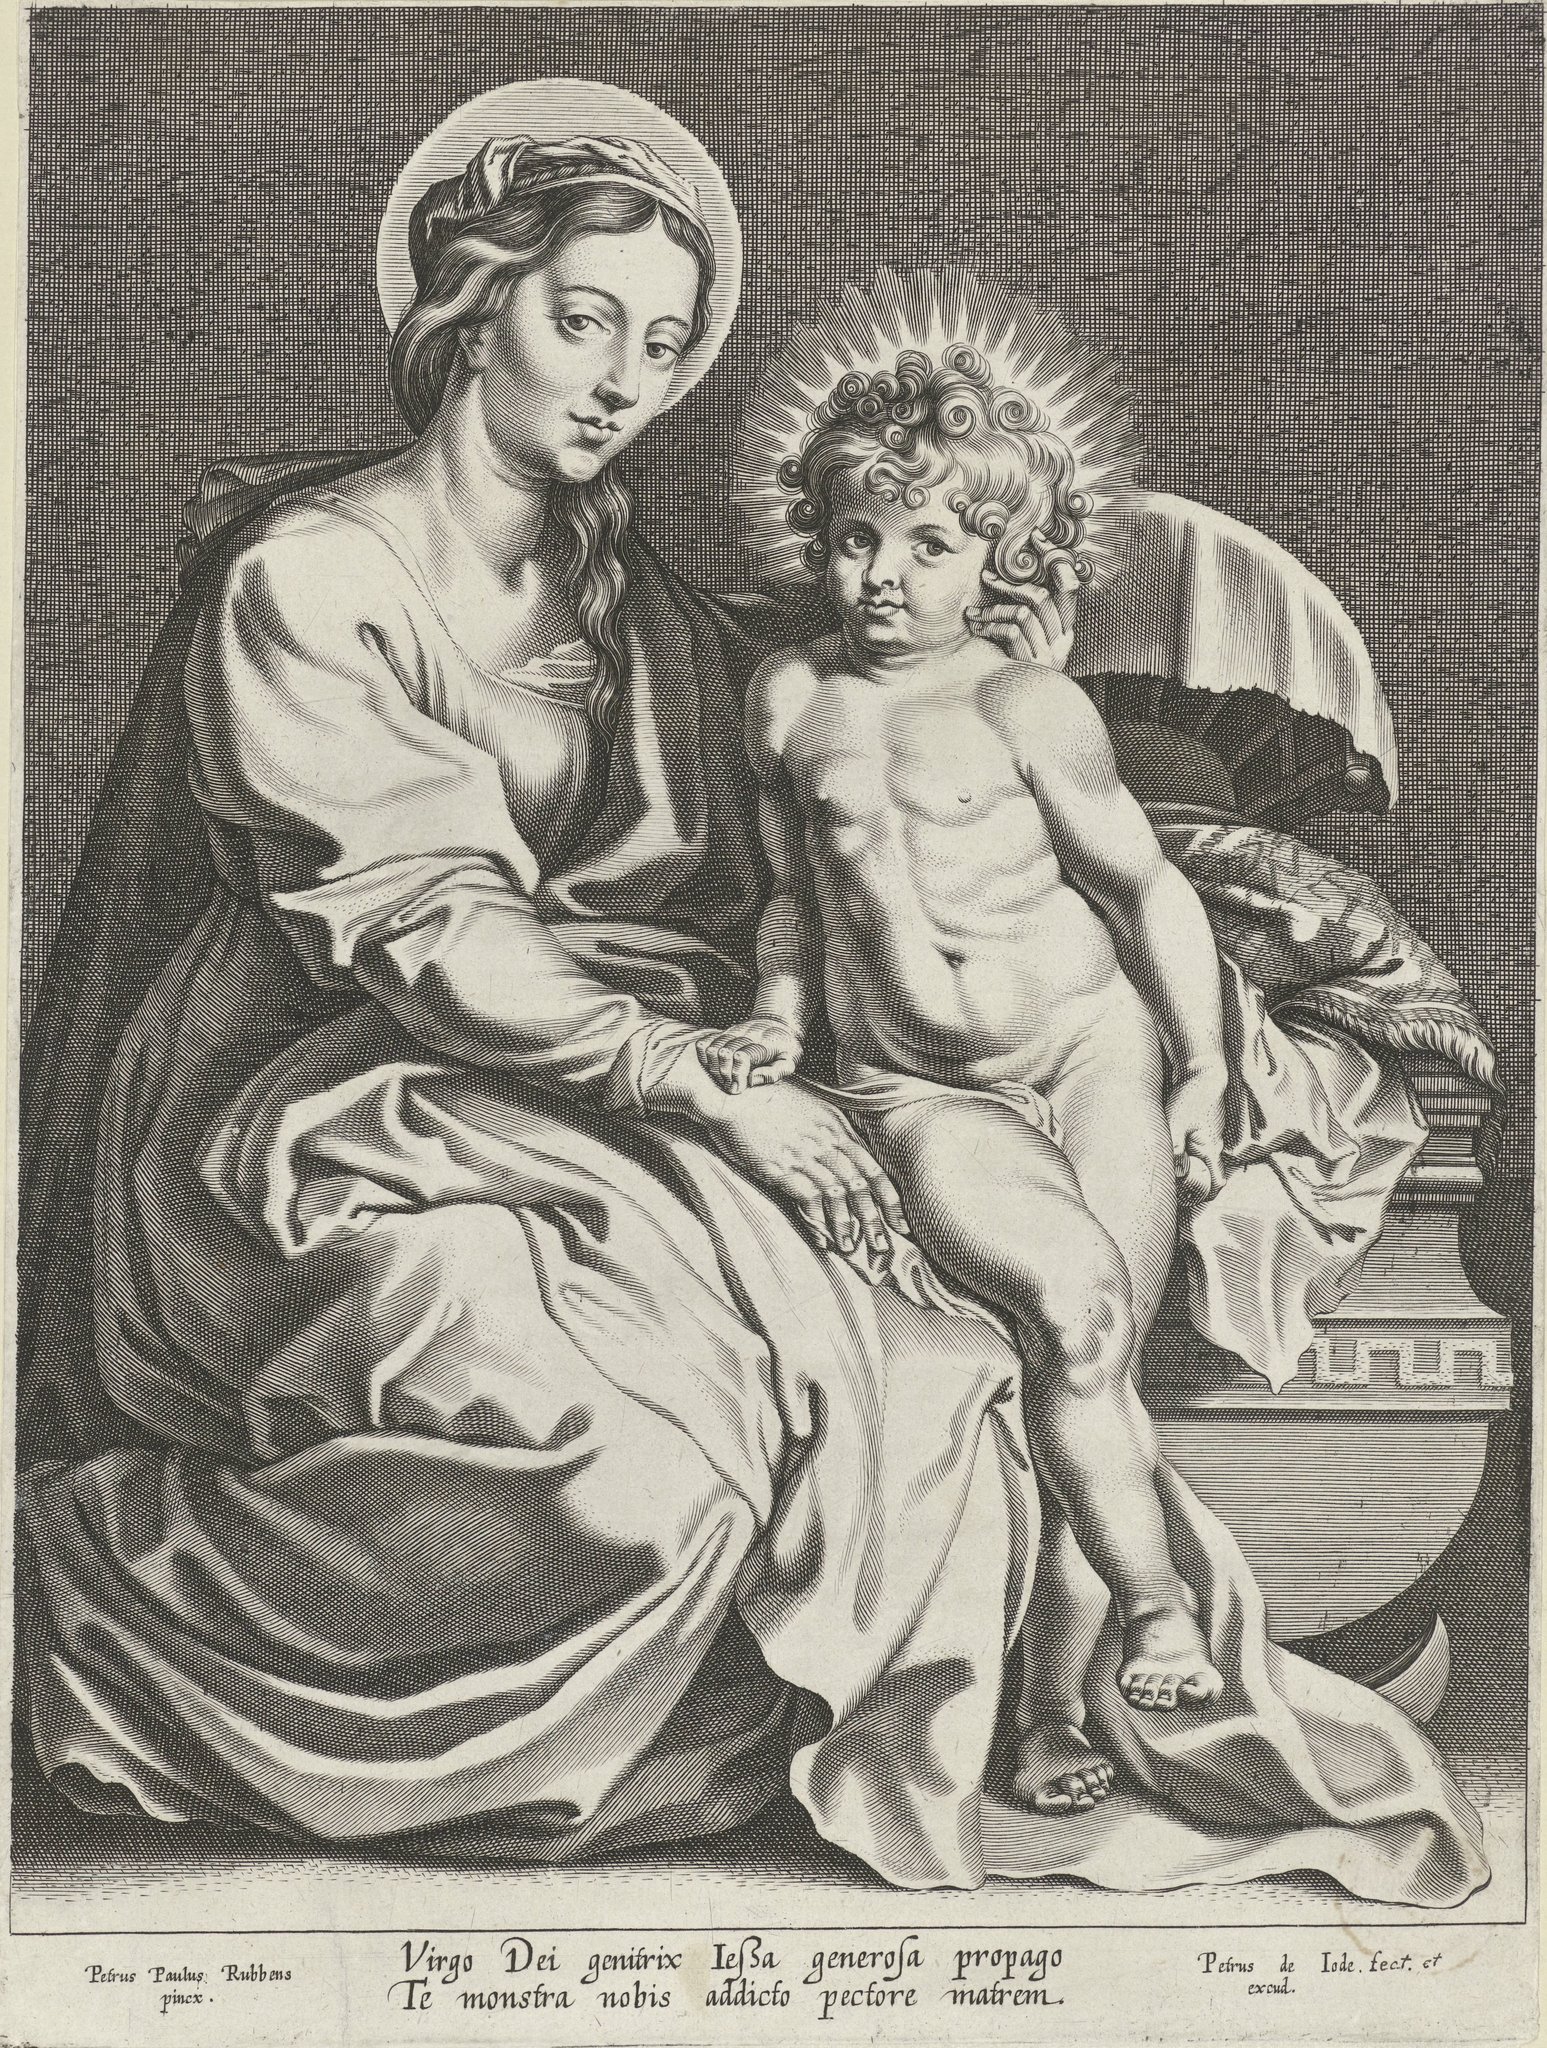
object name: print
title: Maria met Christuskind bij wieg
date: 1590-1632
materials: paper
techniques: engraving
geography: antwerp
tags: cradle, crib, christ-child looking or turning to mary ~ madonna-representations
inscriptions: collector's mark: Lugt 240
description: Maria met het Christuskind, zittend bij een wieg.